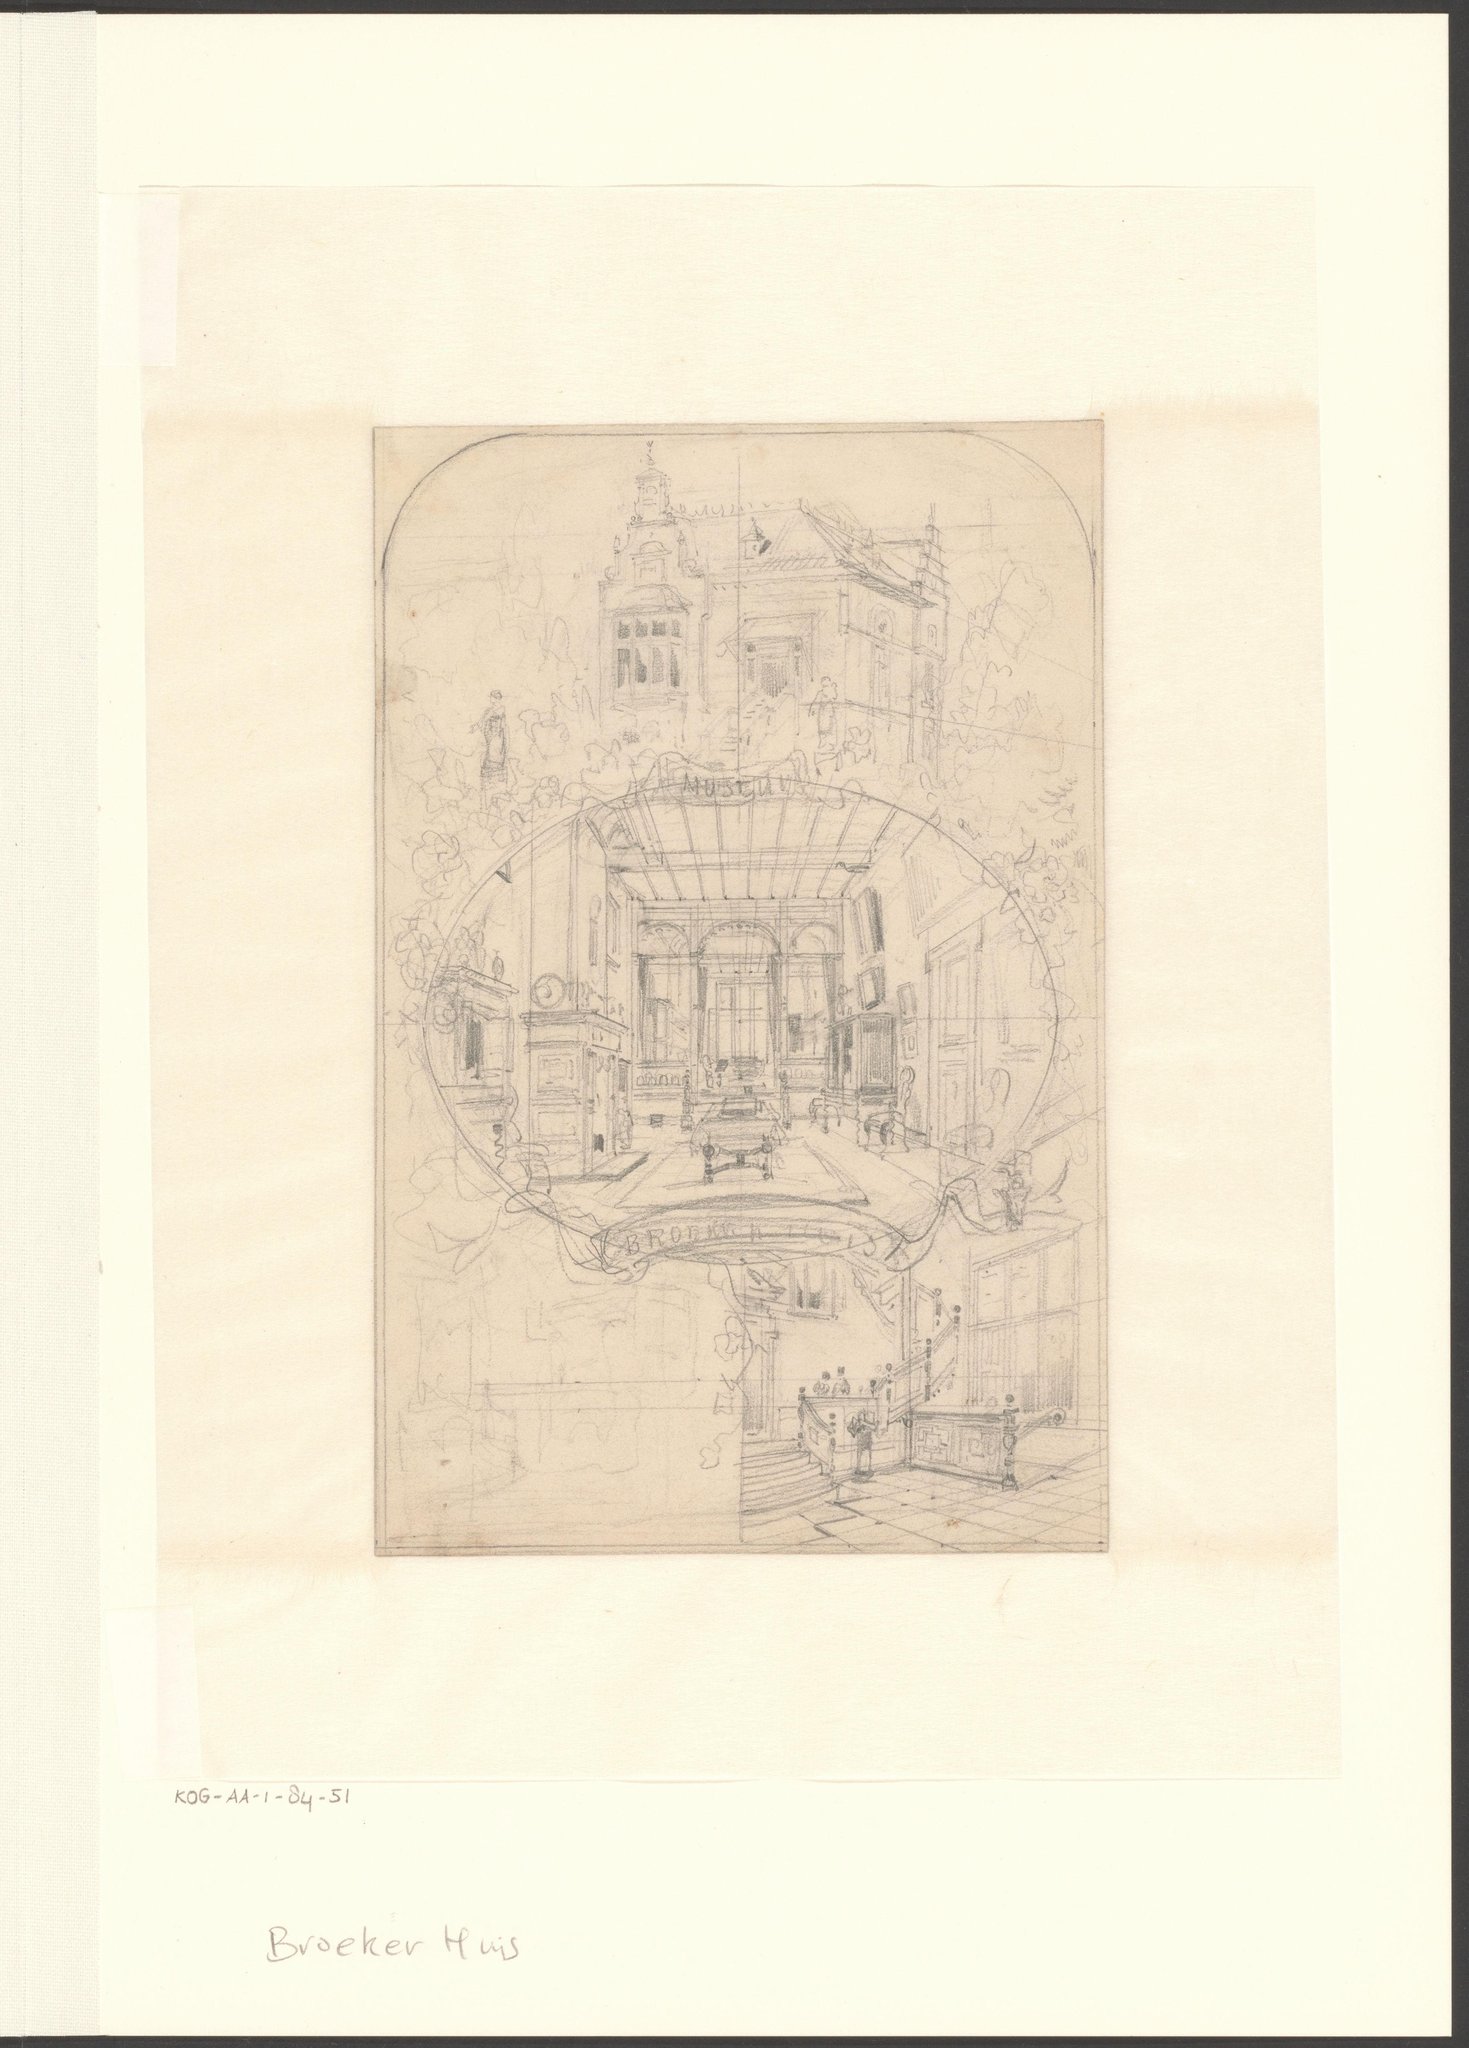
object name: drawing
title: Gezichten op het interieur en exterieur van het Broekerhuis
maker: Anonymous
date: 1882-1887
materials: paper, pencil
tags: village, façade (of house or building), living-room, parlour, sitting-room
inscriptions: inscription: ‘Broeker Huis’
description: Onderwerpsrubriek binnen de Atlas Amsterdam: Amstelveenseweg.